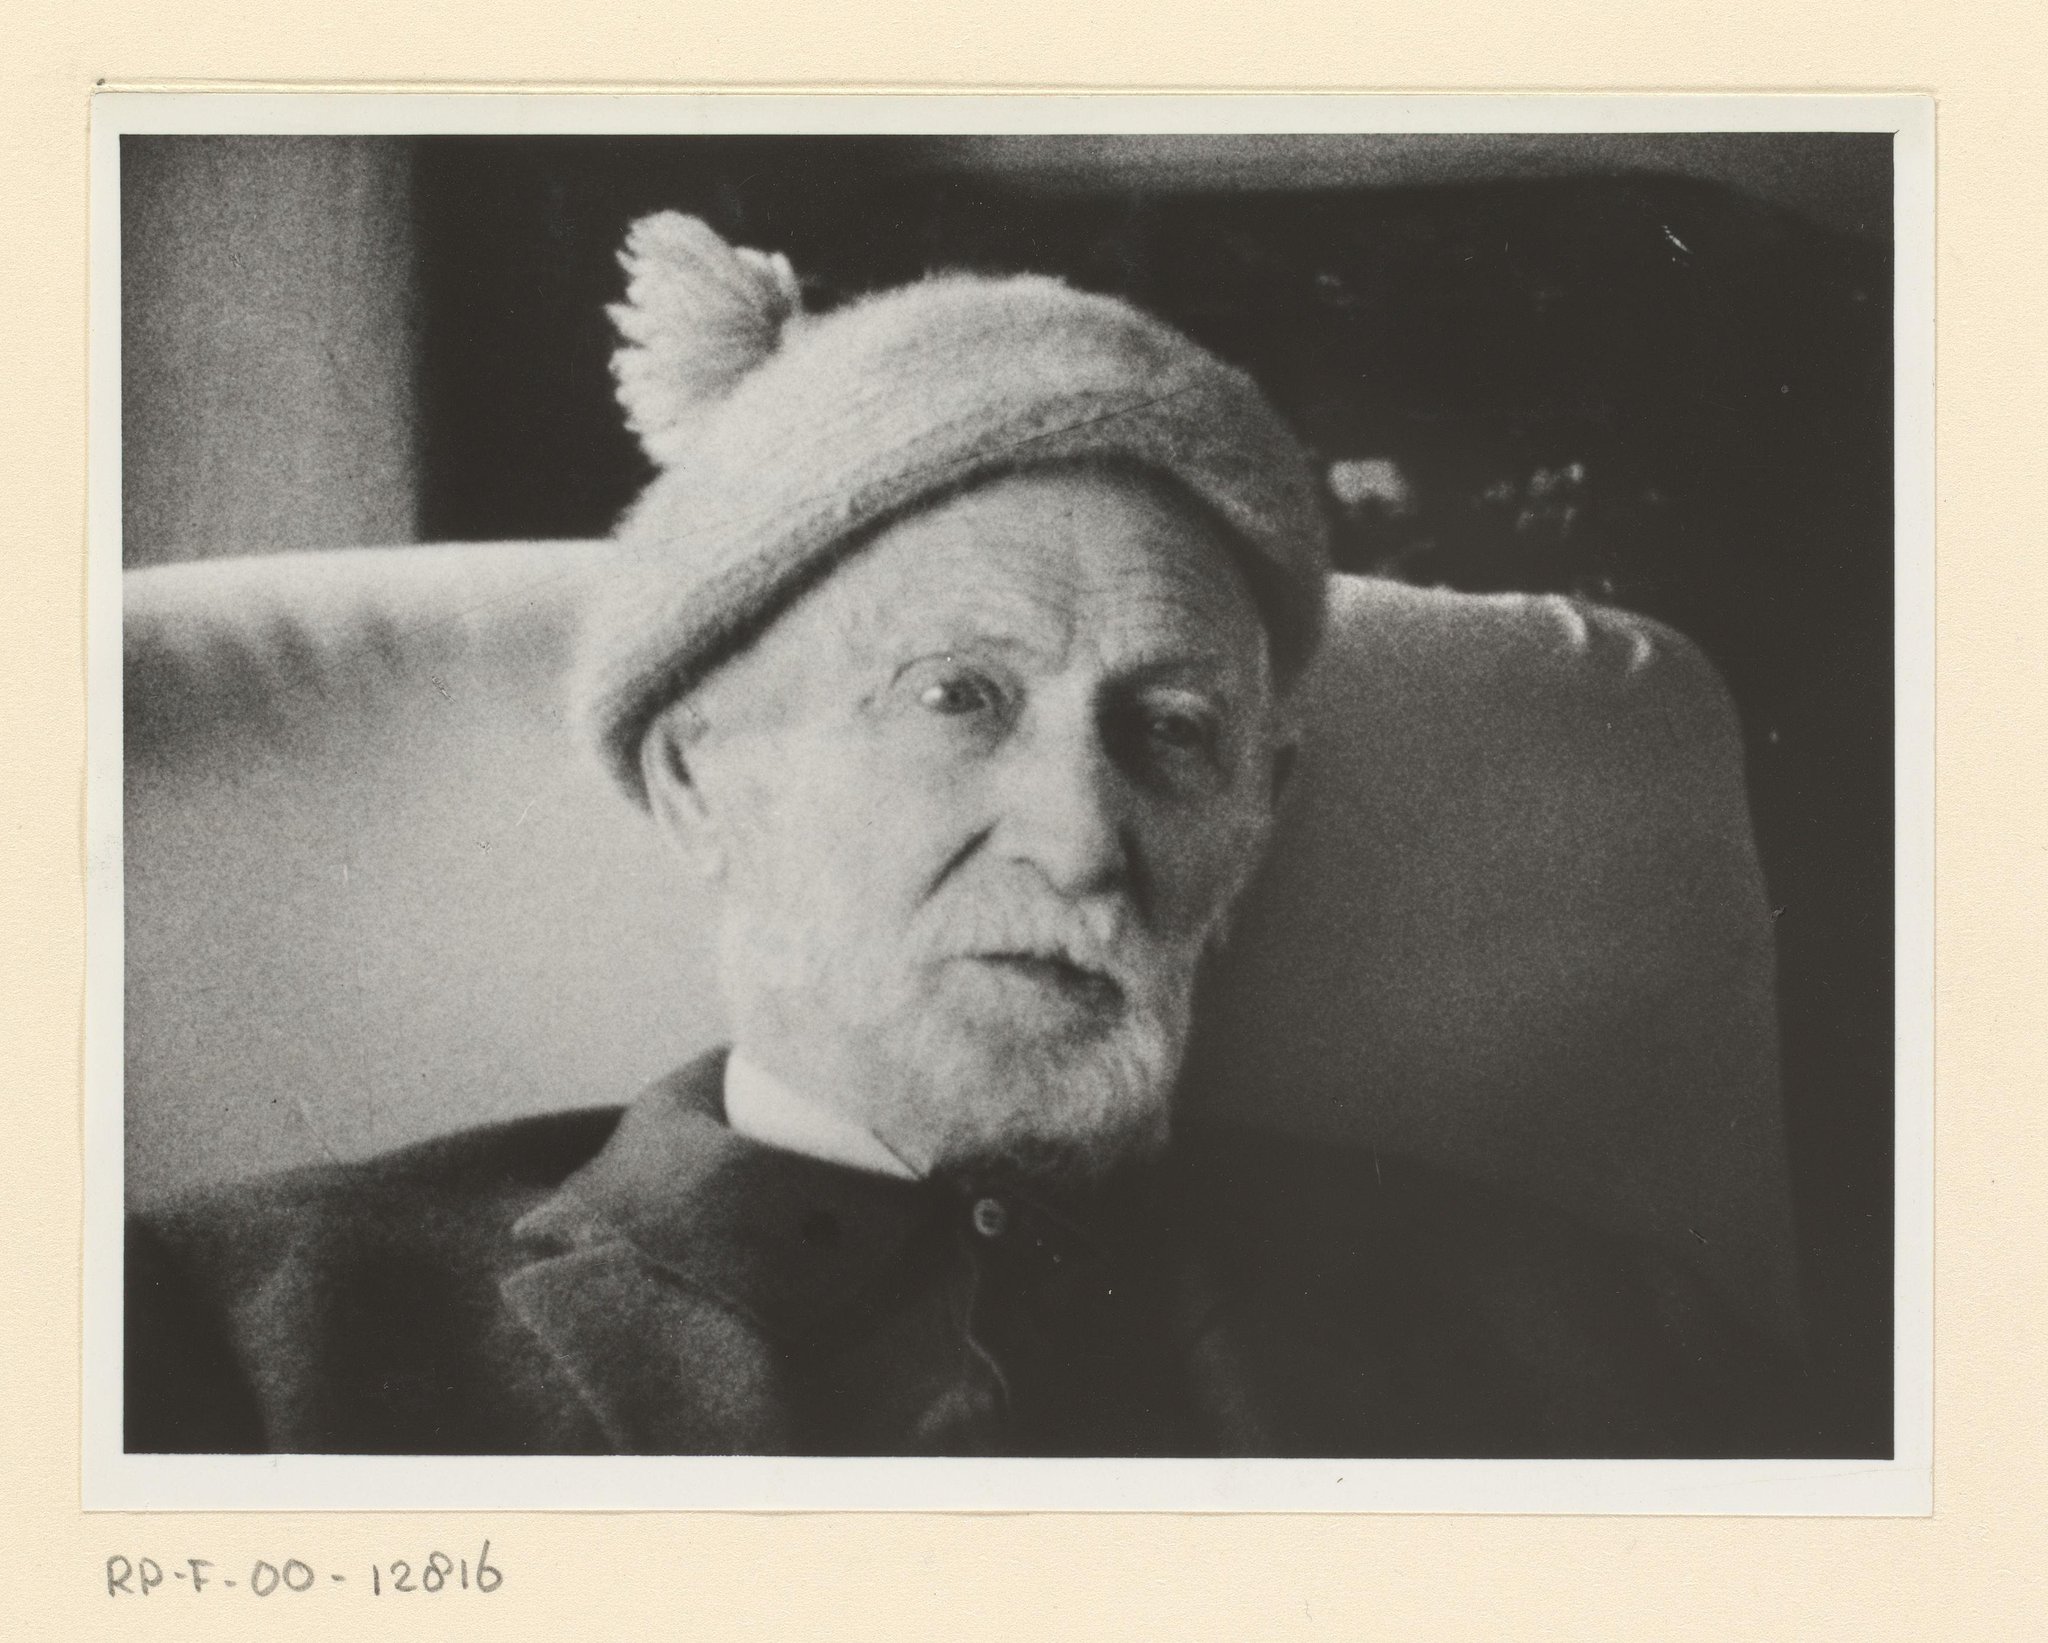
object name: photograph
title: Portret van Kees van Dongen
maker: Anonymous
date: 1965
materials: paper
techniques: gelatin silver print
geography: monaco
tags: utrecht, historical persons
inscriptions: inscription: ‘Kees van Dongen/ neg 13/18: 17941/ overgenomen van 16mm film/ overname door V.P.R.O. televisieploeg op 10 februari 1965/ ten huize van Kees van Dongen, Avenue Hector Otto 7, Monaco/ onderdeel programma atelierbezoek bij Kees van Dongen/ uitgezonden op 25 februari 65 over Nederland II/ regie: L. Westenburg/ camera: W. Smith/ presentatie en samenstelling: E.R. Meijer.’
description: Filmstill uit een televisieprogramma met een atelierbezoek aan Kees van Dongen, gemaakt door V.P.R.O. en uitgezonden op 25 februari 1965.